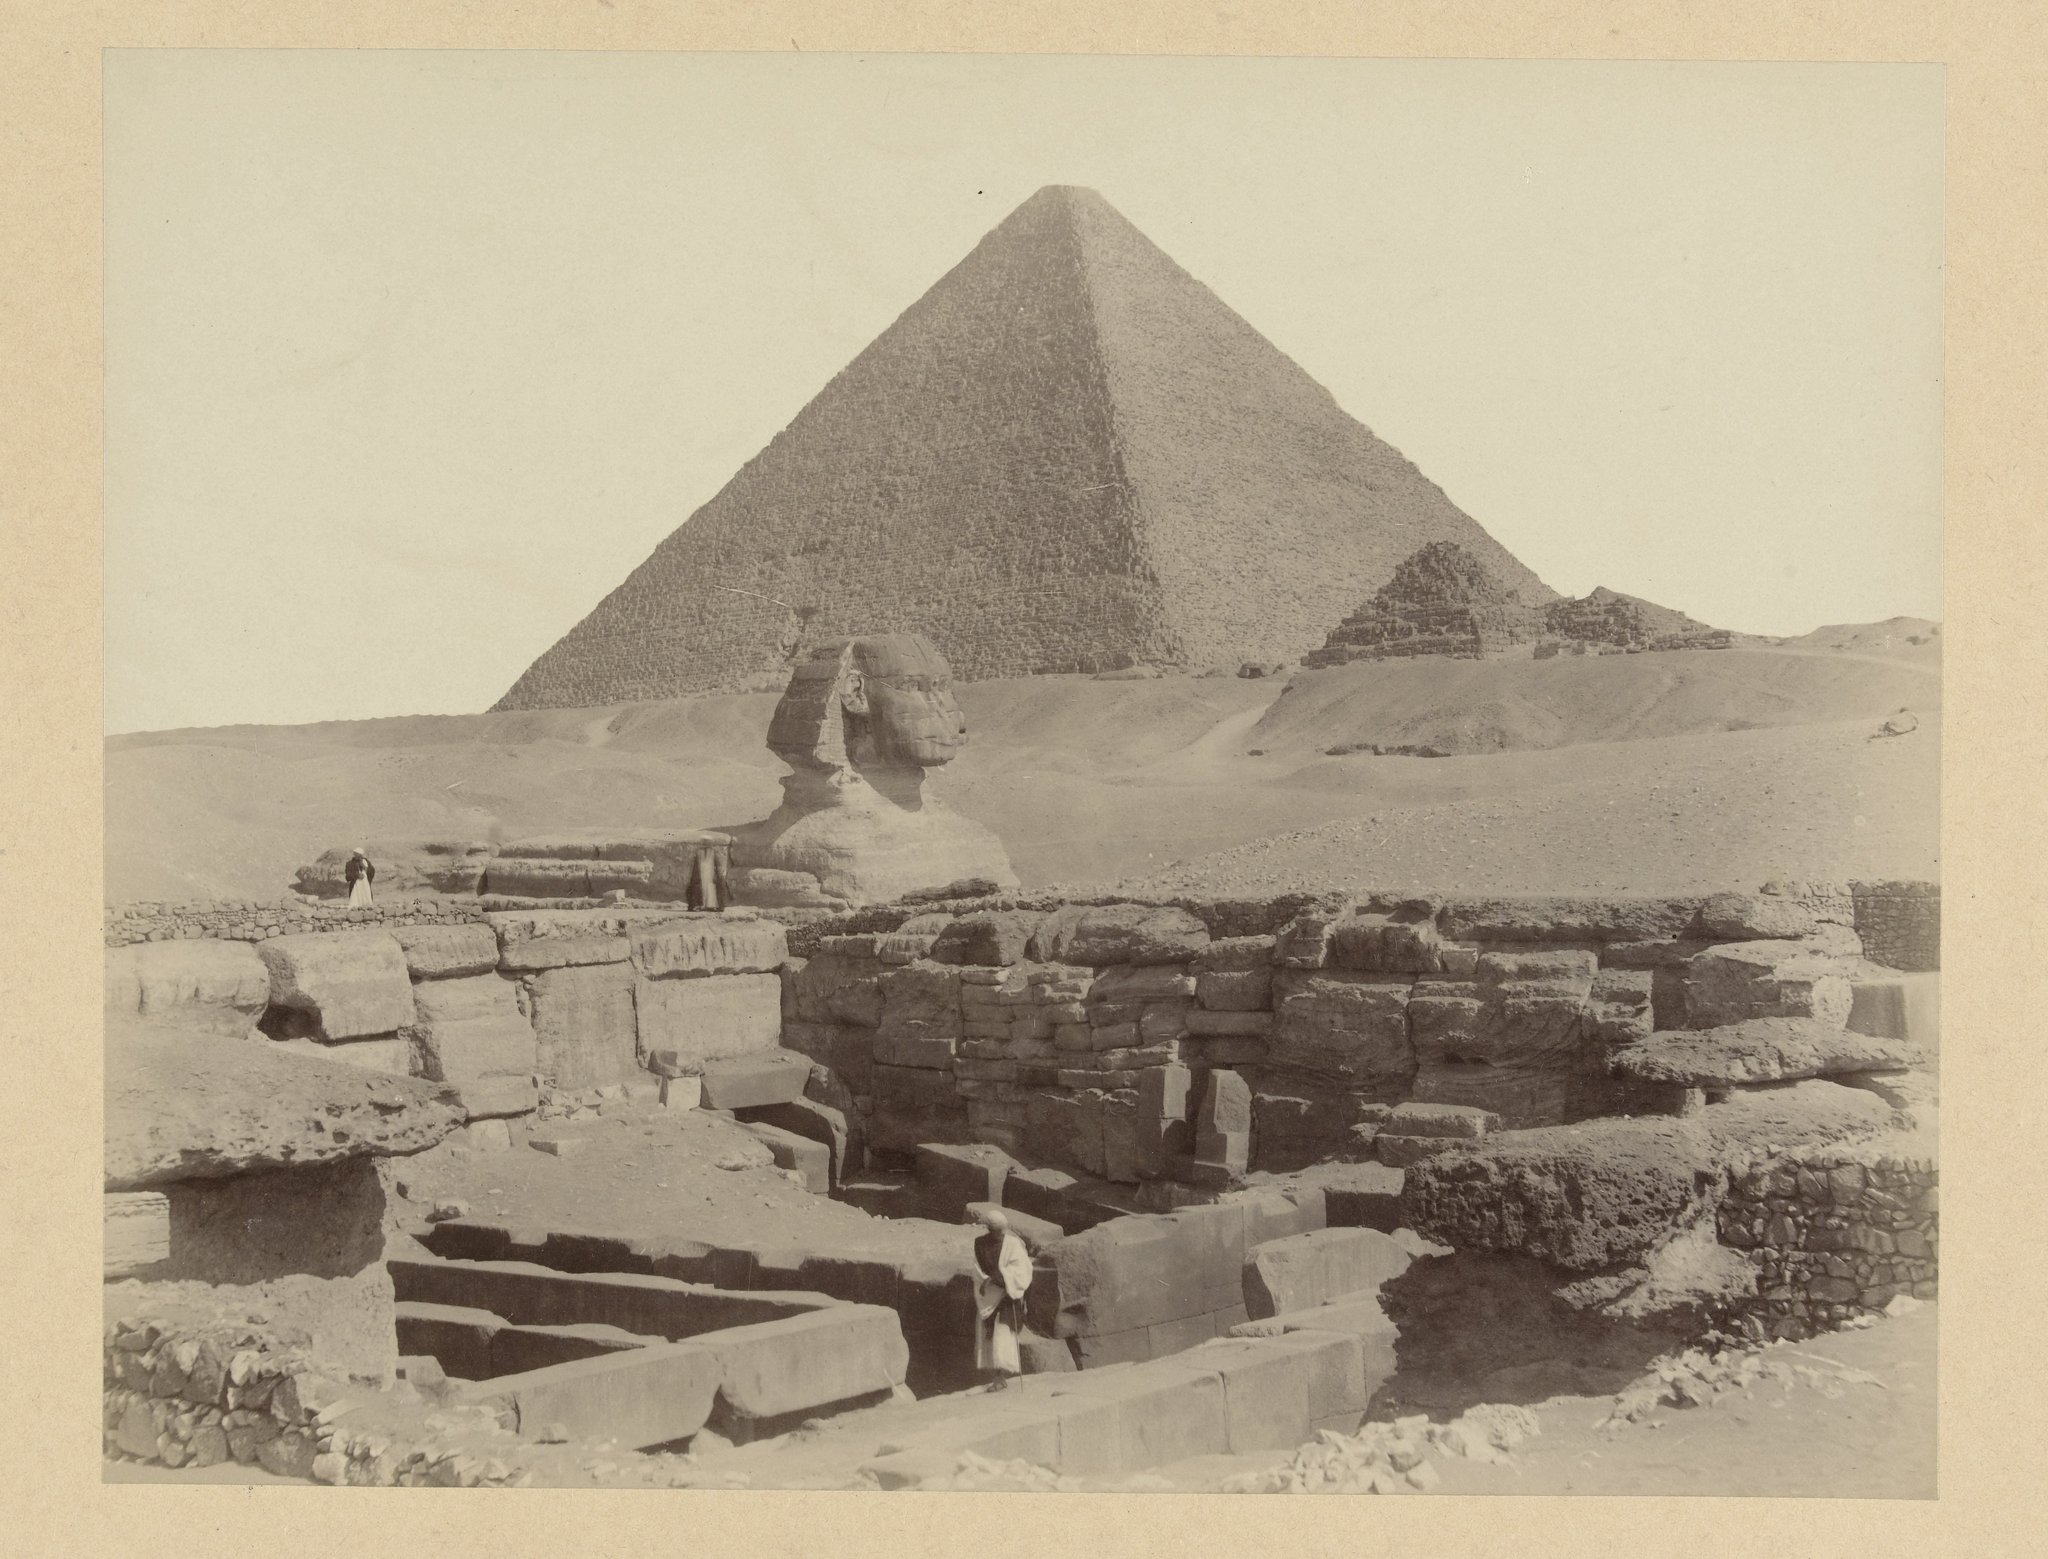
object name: photograph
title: Piramide van Cheops en sfinx van Gizeh, met op de voorgrond tempels en koninklijke graven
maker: Anonymous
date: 1890-1895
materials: cardboard, paper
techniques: albumen print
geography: gizeh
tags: sphinx (lion/woman); 'sfinge' (ripa), egyptian pyramids (wonder of the world), pyramid (historical grave form), excavation ~ archaeology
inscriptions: stamp: ‘Gemeentelijke bibliotheek/ Rotterdam’, check stamp: ‘Bristol/ L.M.’, title: ‘E 53. Koninklijke graven bij de pyramiden. Caïro.’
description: Onderdeel van een groep door fotograaf Richard Polak op reis verzamelde foto’s. Deze foto is samen met andere op zijn reizen verzamelde foto's tentoongesteld bij de Rotterdamsche Kunstkring (1895), Arti en Amicitiae te Amsterdam (1897-1898?) en Societeit 't Collegie te Kampen (datum vooralsnog onbekend).